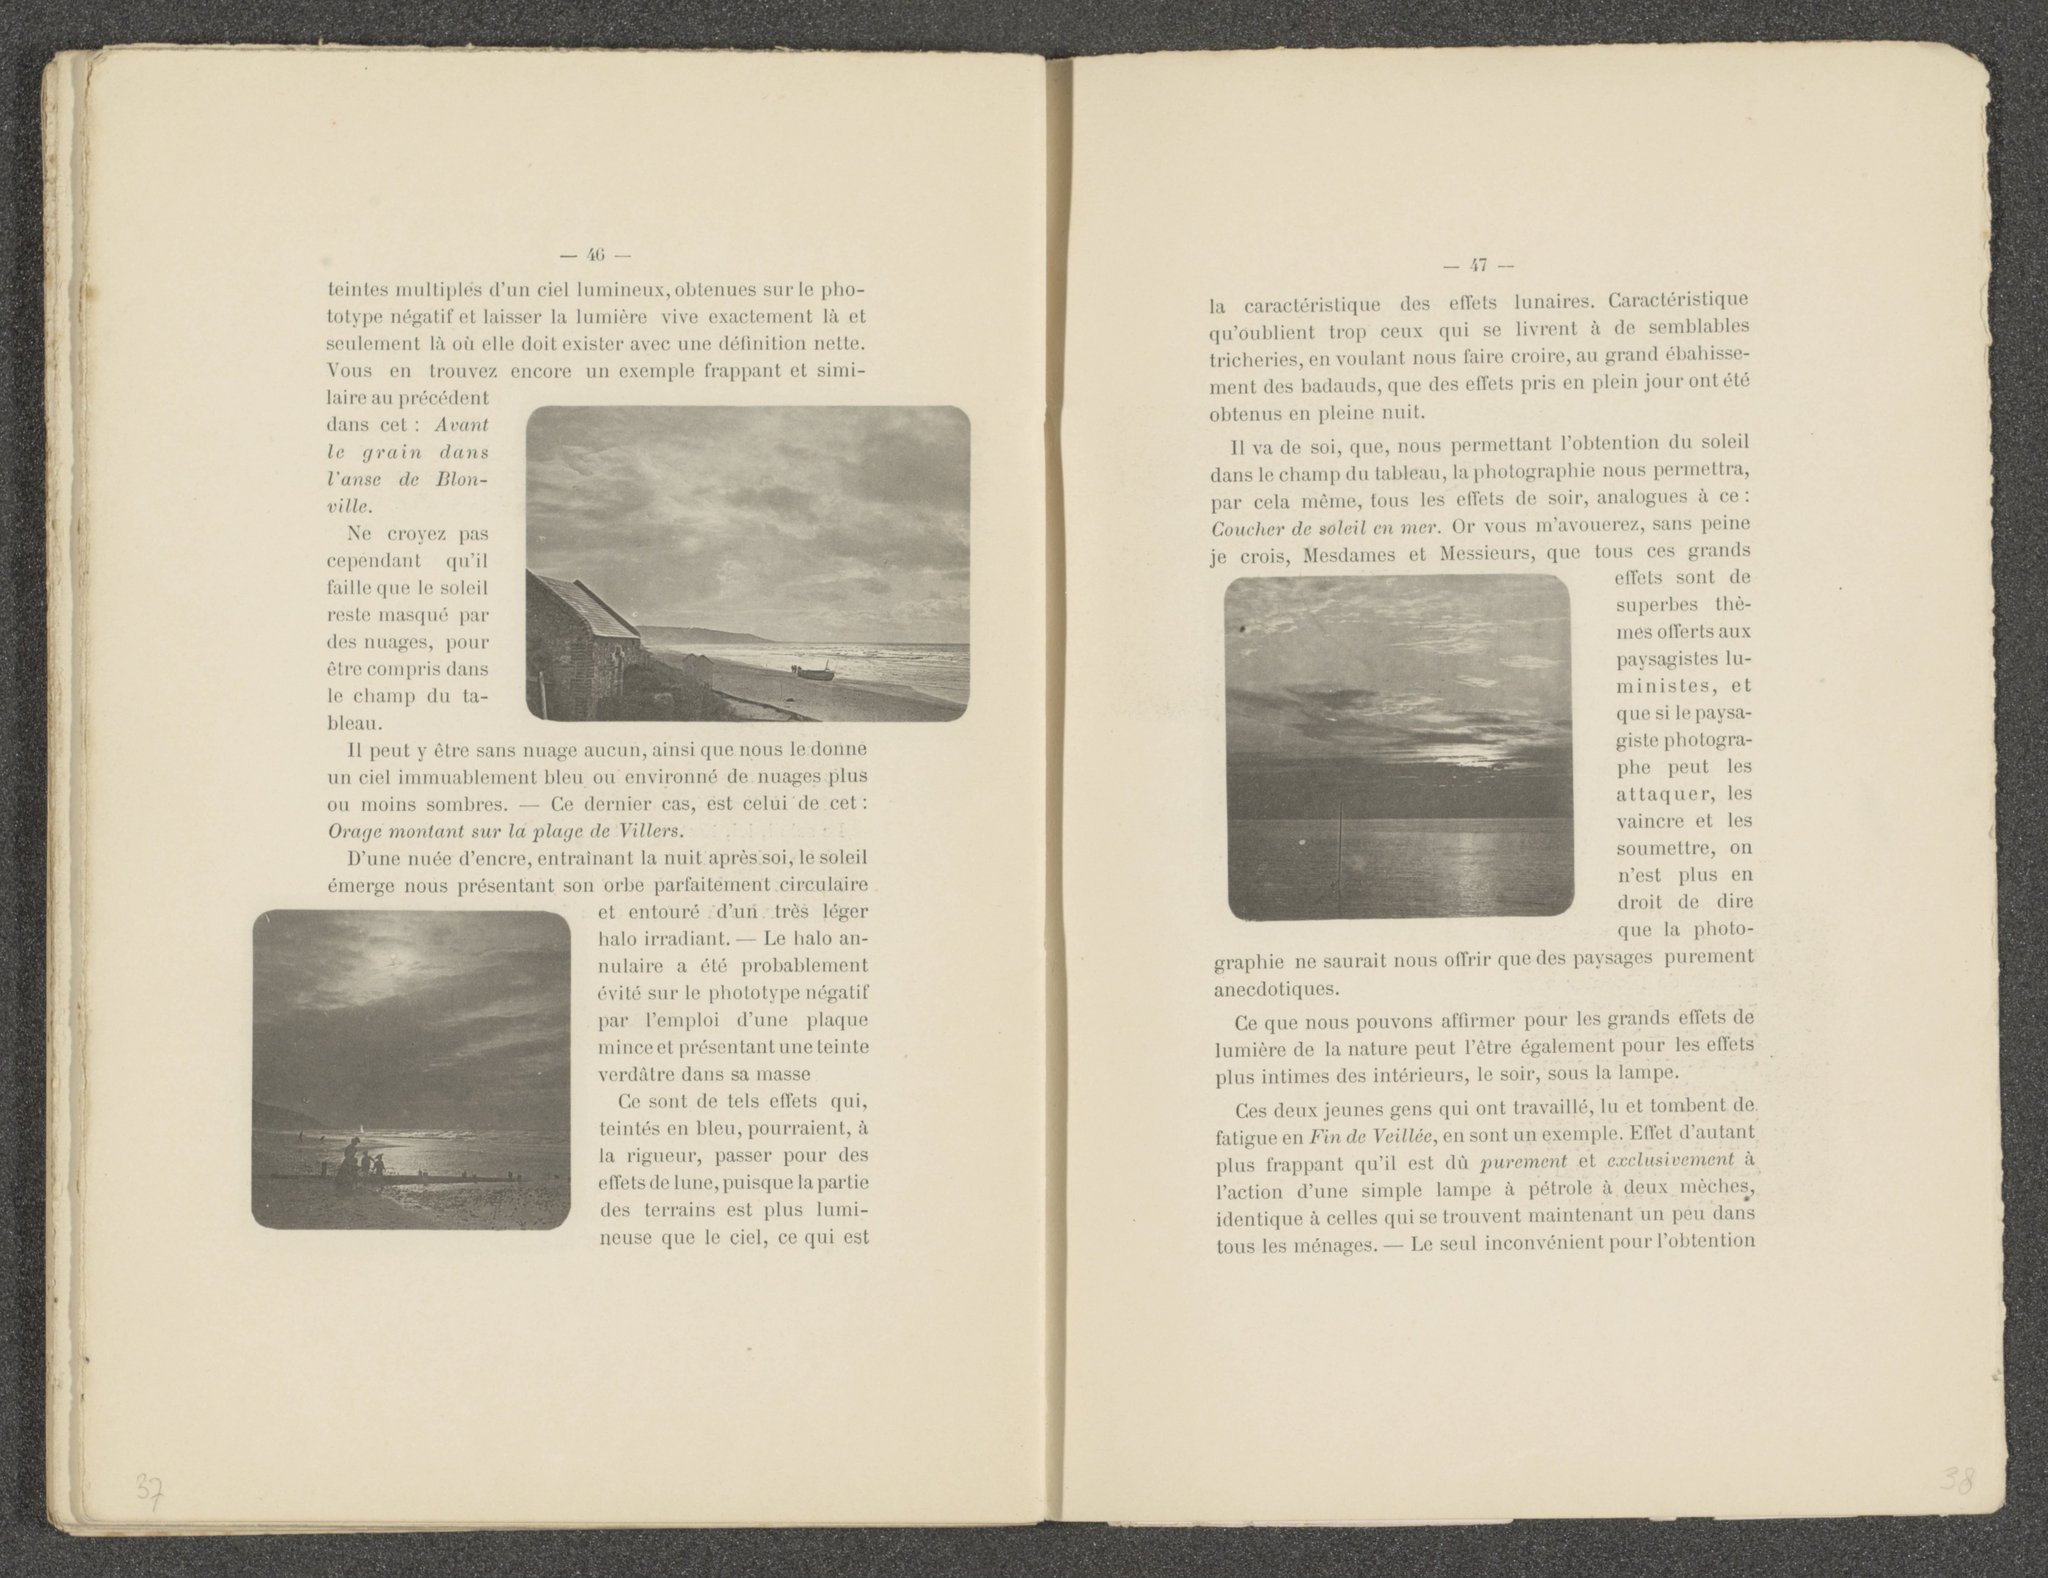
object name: page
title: Ondergaande zon boven de zee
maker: Anonymous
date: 1886-1896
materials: paper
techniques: photograph, printing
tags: sunset, sea